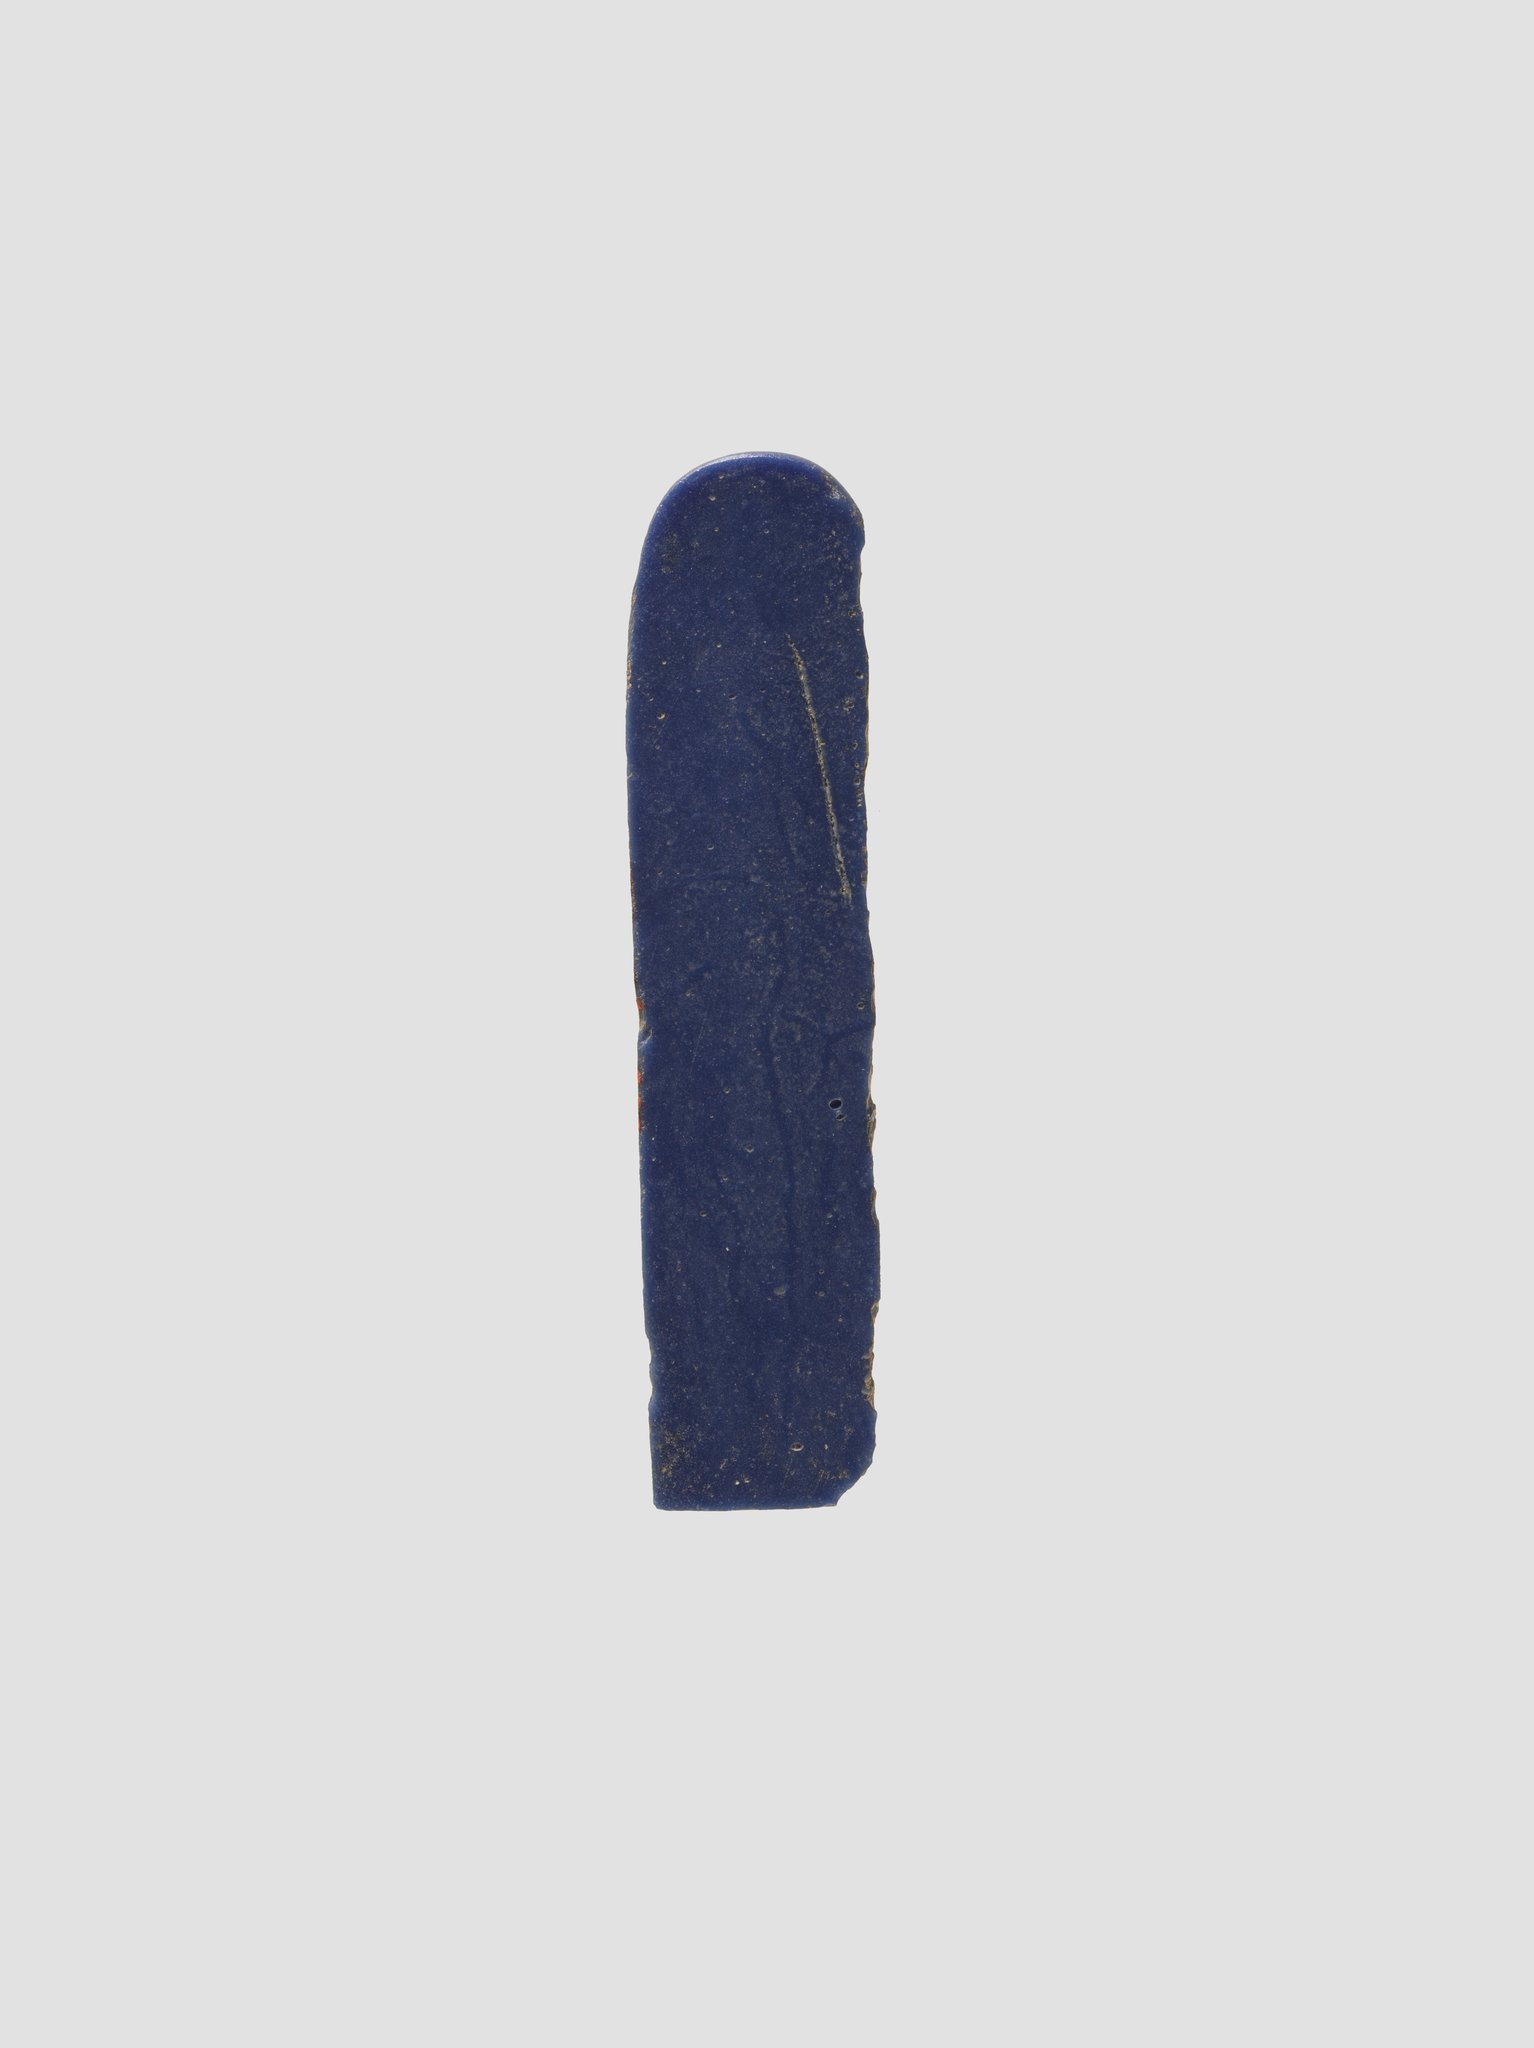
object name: inlay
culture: assyrian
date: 800-601 BCE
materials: glass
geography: mesopotamia